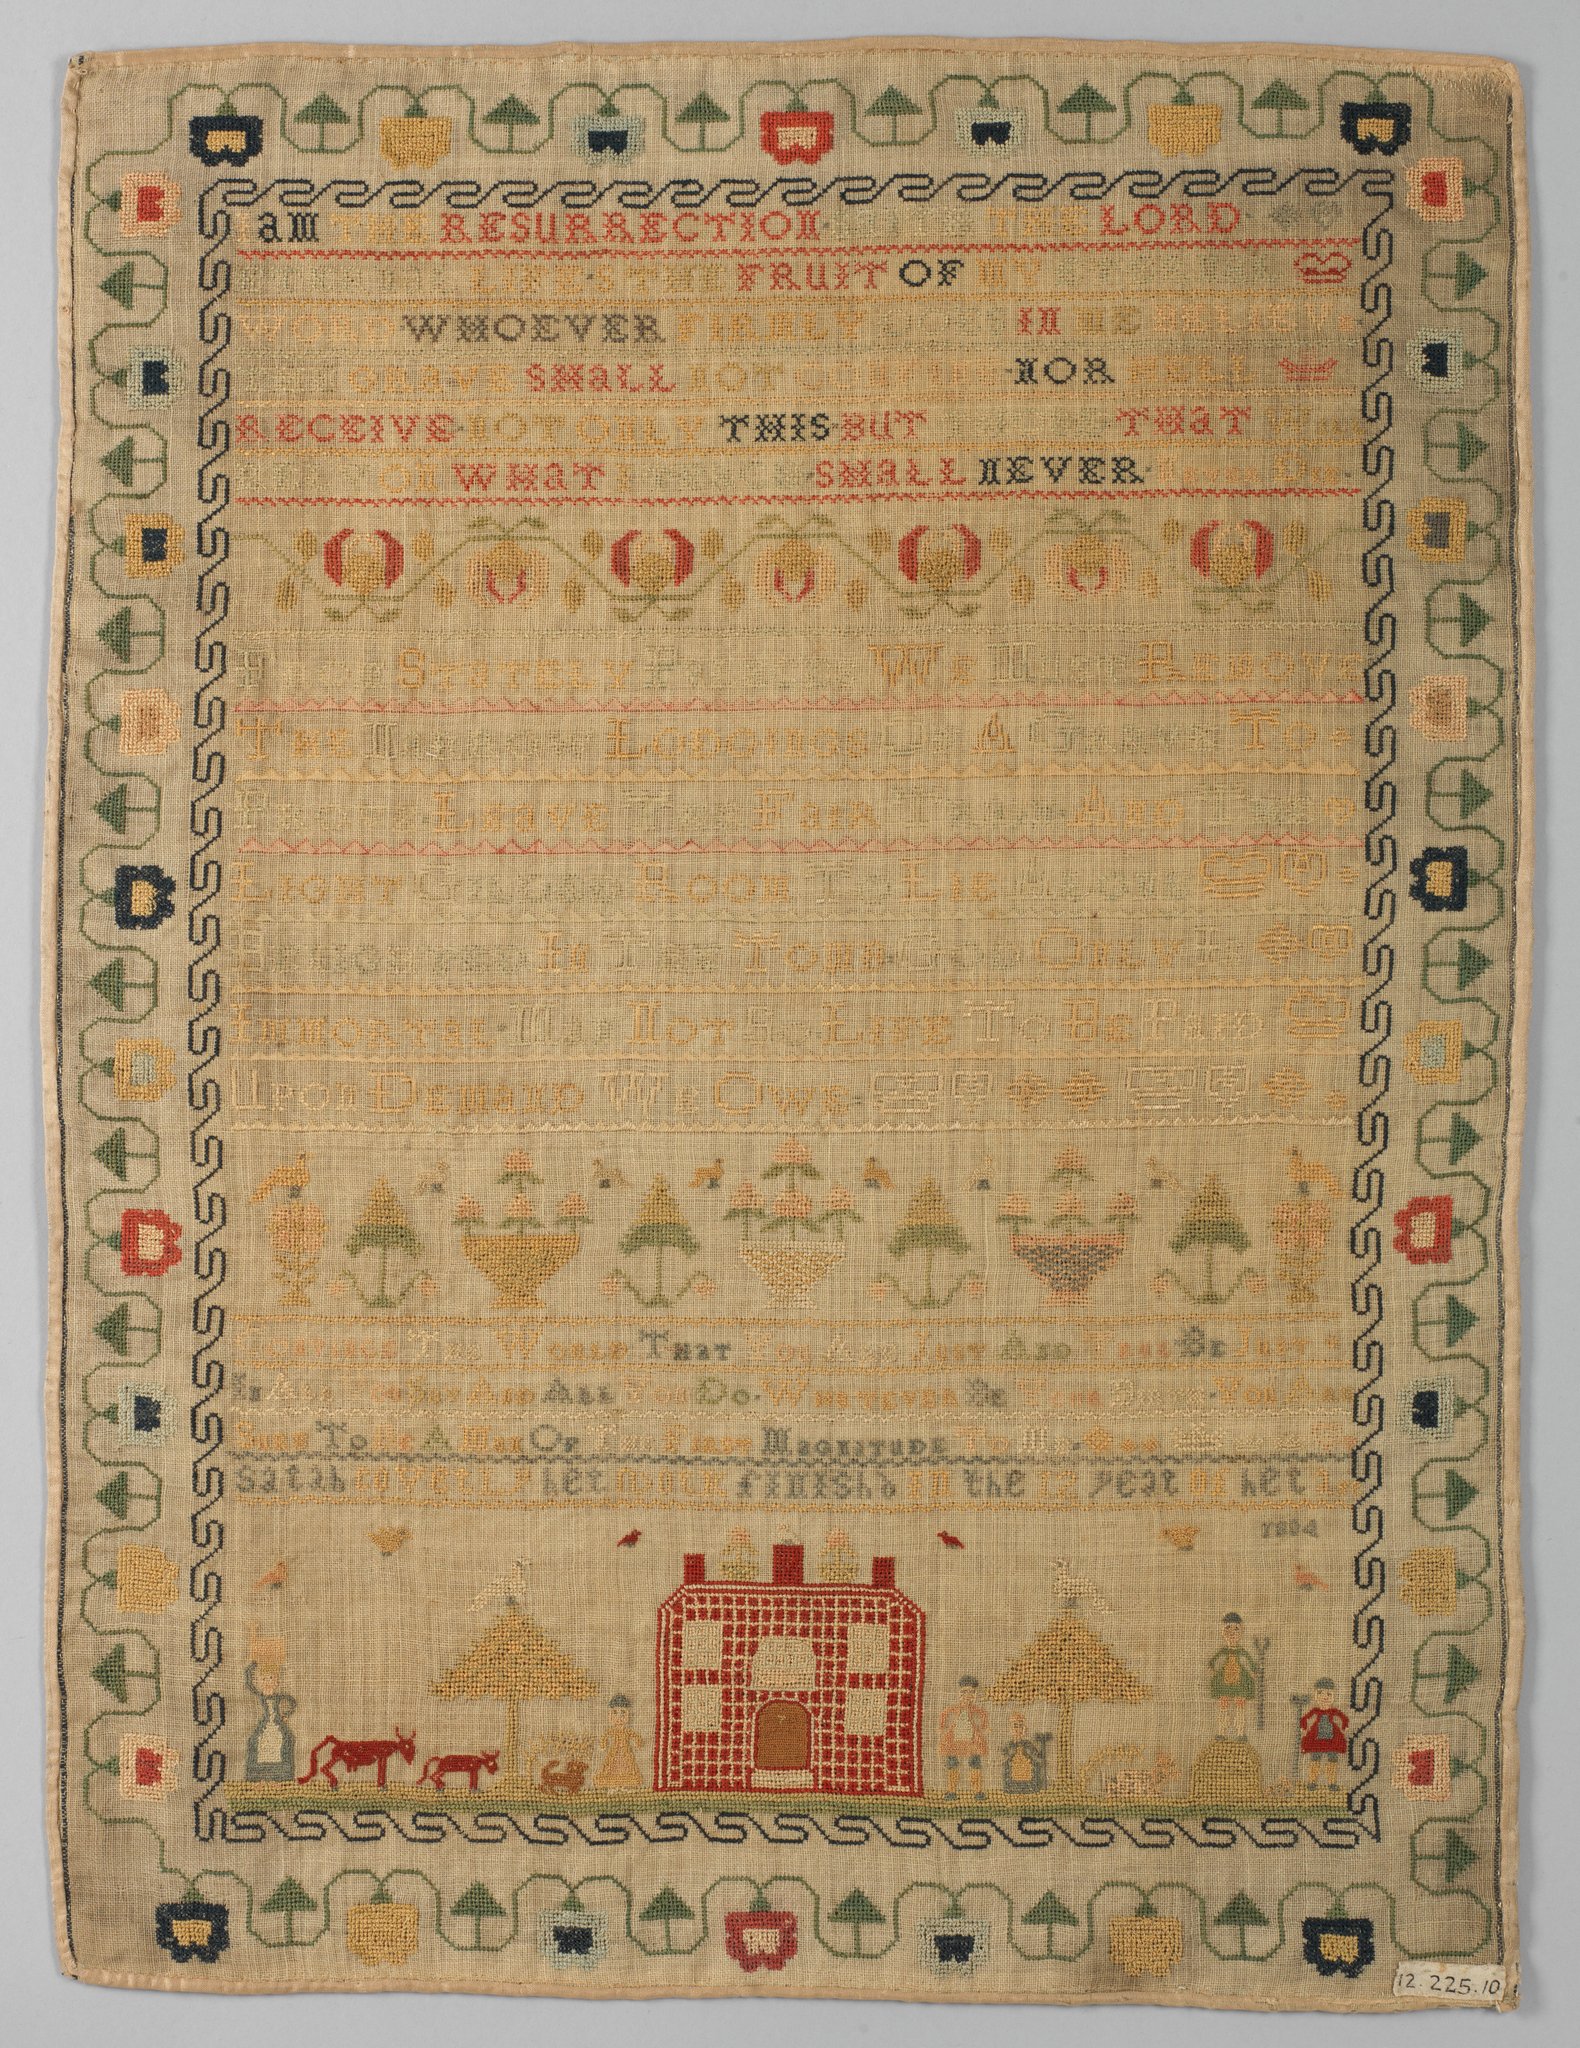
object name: sampler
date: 1804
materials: linen, silk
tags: human figures,animals,houses